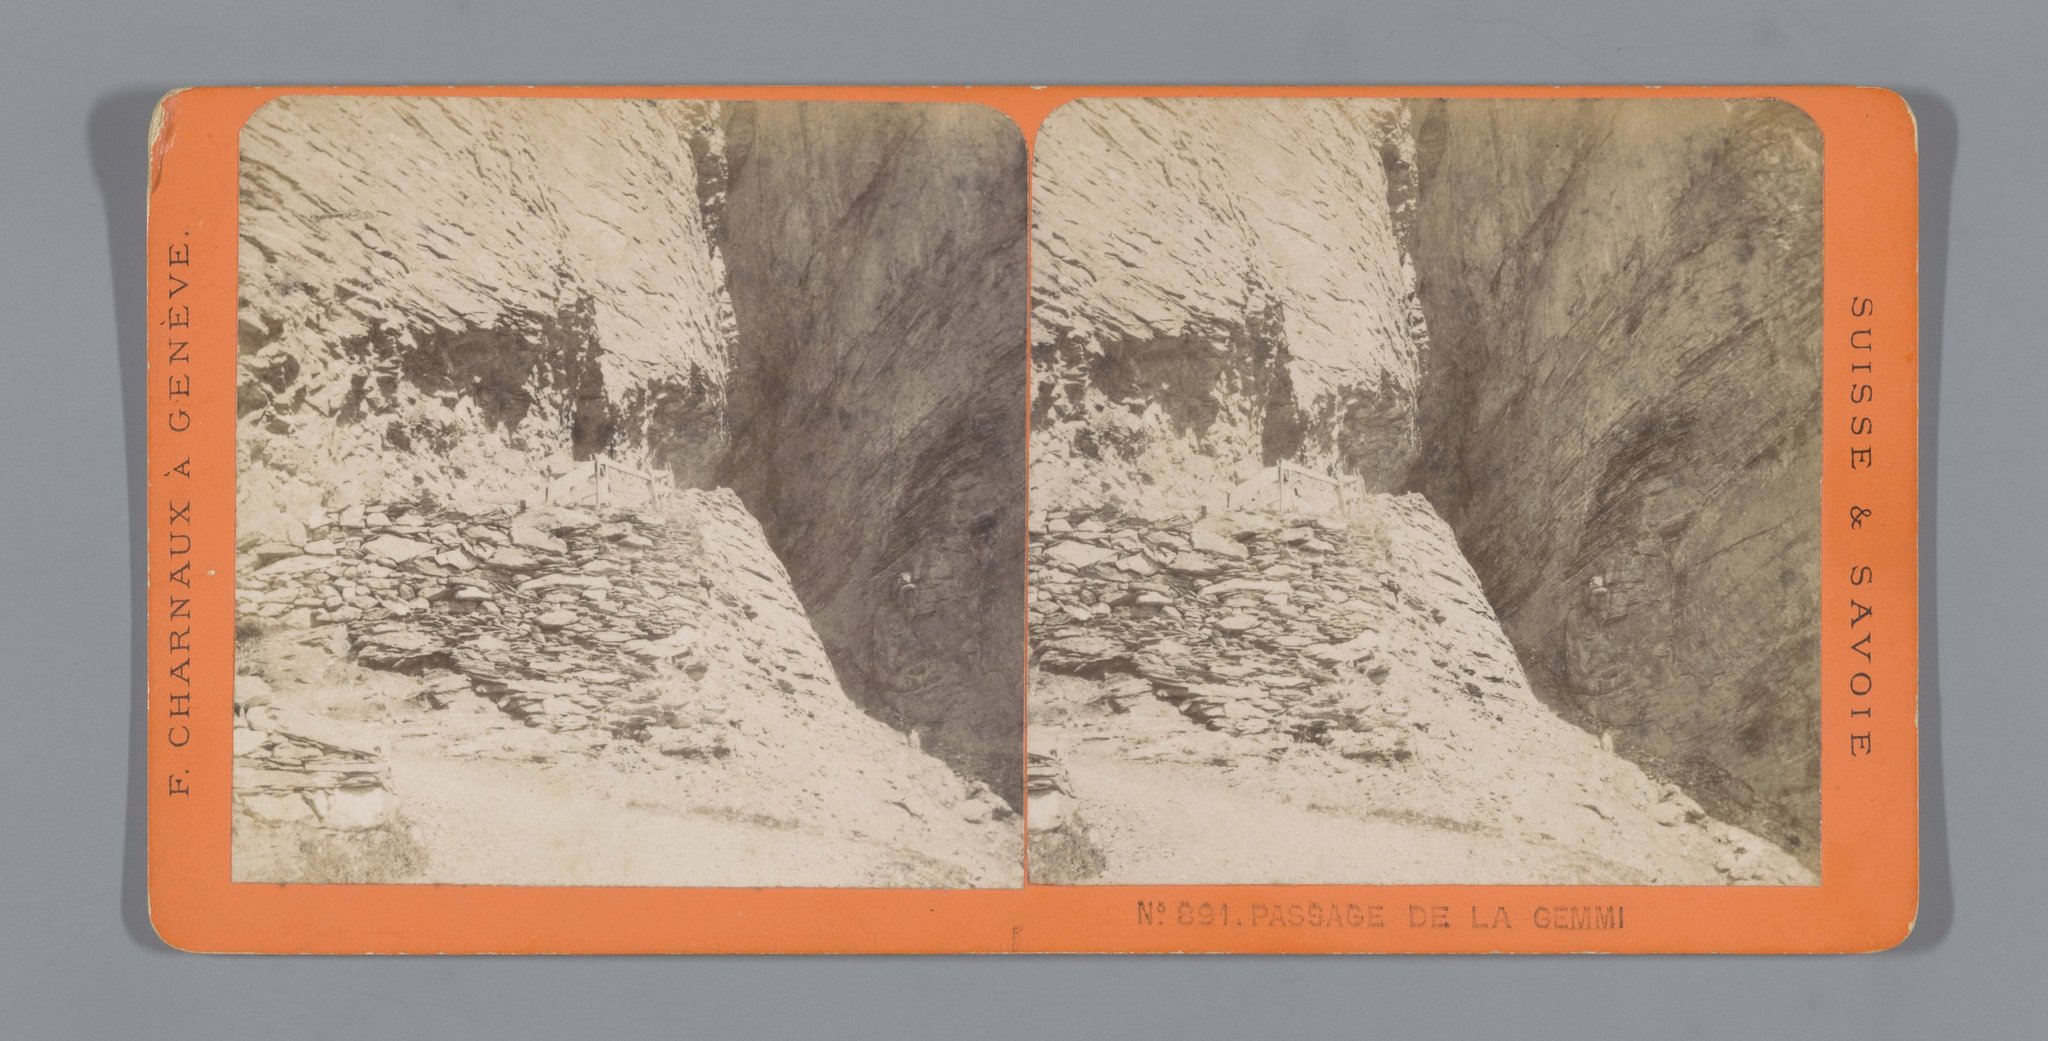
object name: stereograph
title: Gezicht op de Gemmipas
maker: florentin charnaux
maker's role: publisher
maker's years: 1819-1883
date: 1879-1885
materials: cardboard, photographic support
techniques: albumen print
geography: bern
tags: road, path, mountains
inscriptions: number: ‘No 891.’, annotation: ‘Paris 1870 Lyon 1872 Vienne 1873 Philadelphia 1876 Paris 1878 Paris 1879 Maison des Trois Rois - F. Charnaux Genève.’, inscription: ‘Suisse & Savoie’